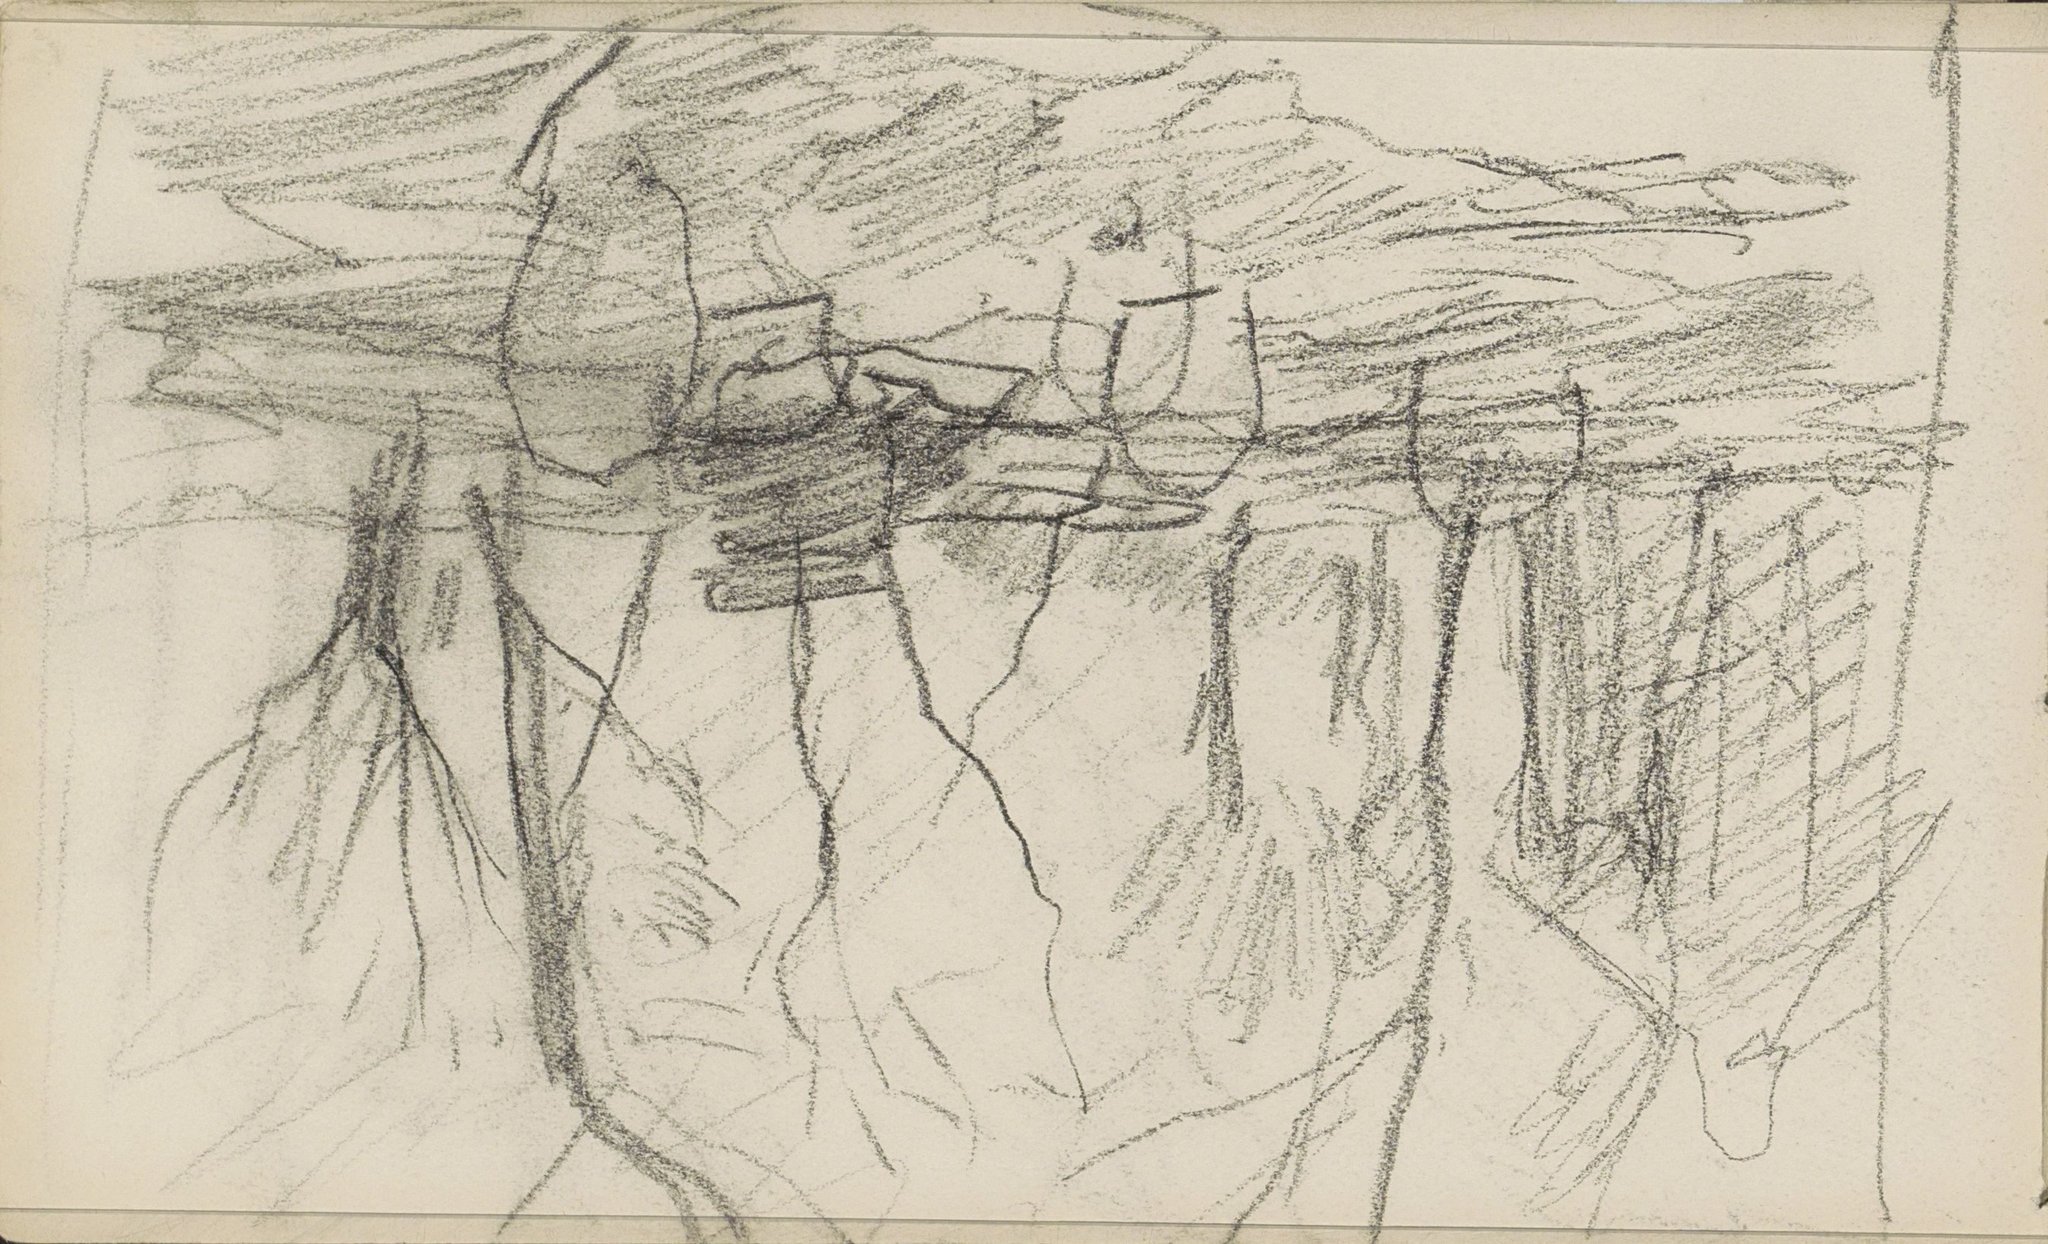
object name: sketchbook leaf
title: Landschap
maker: anton mauve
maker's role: draughtsman, painter, print maker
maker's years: 1838-1888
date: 1848-1888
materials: chalk, paper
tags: landscapes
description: Blad 21 verso uit een schetsboek met 33 bladen.